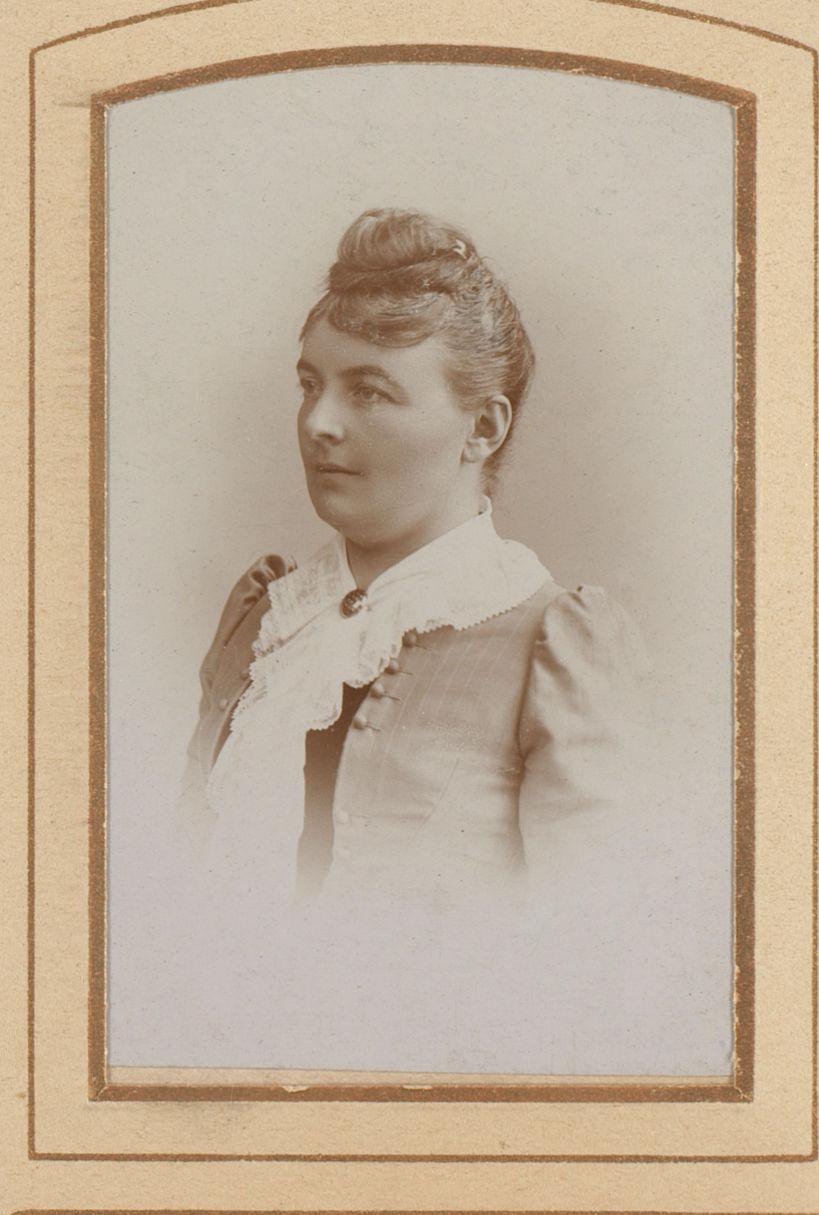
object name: photograph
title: Portret van een vrouw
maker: Anonymous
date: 1870-1900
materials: cardboard, photographic support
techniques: collodion silver print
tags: historical persons - bb - woman